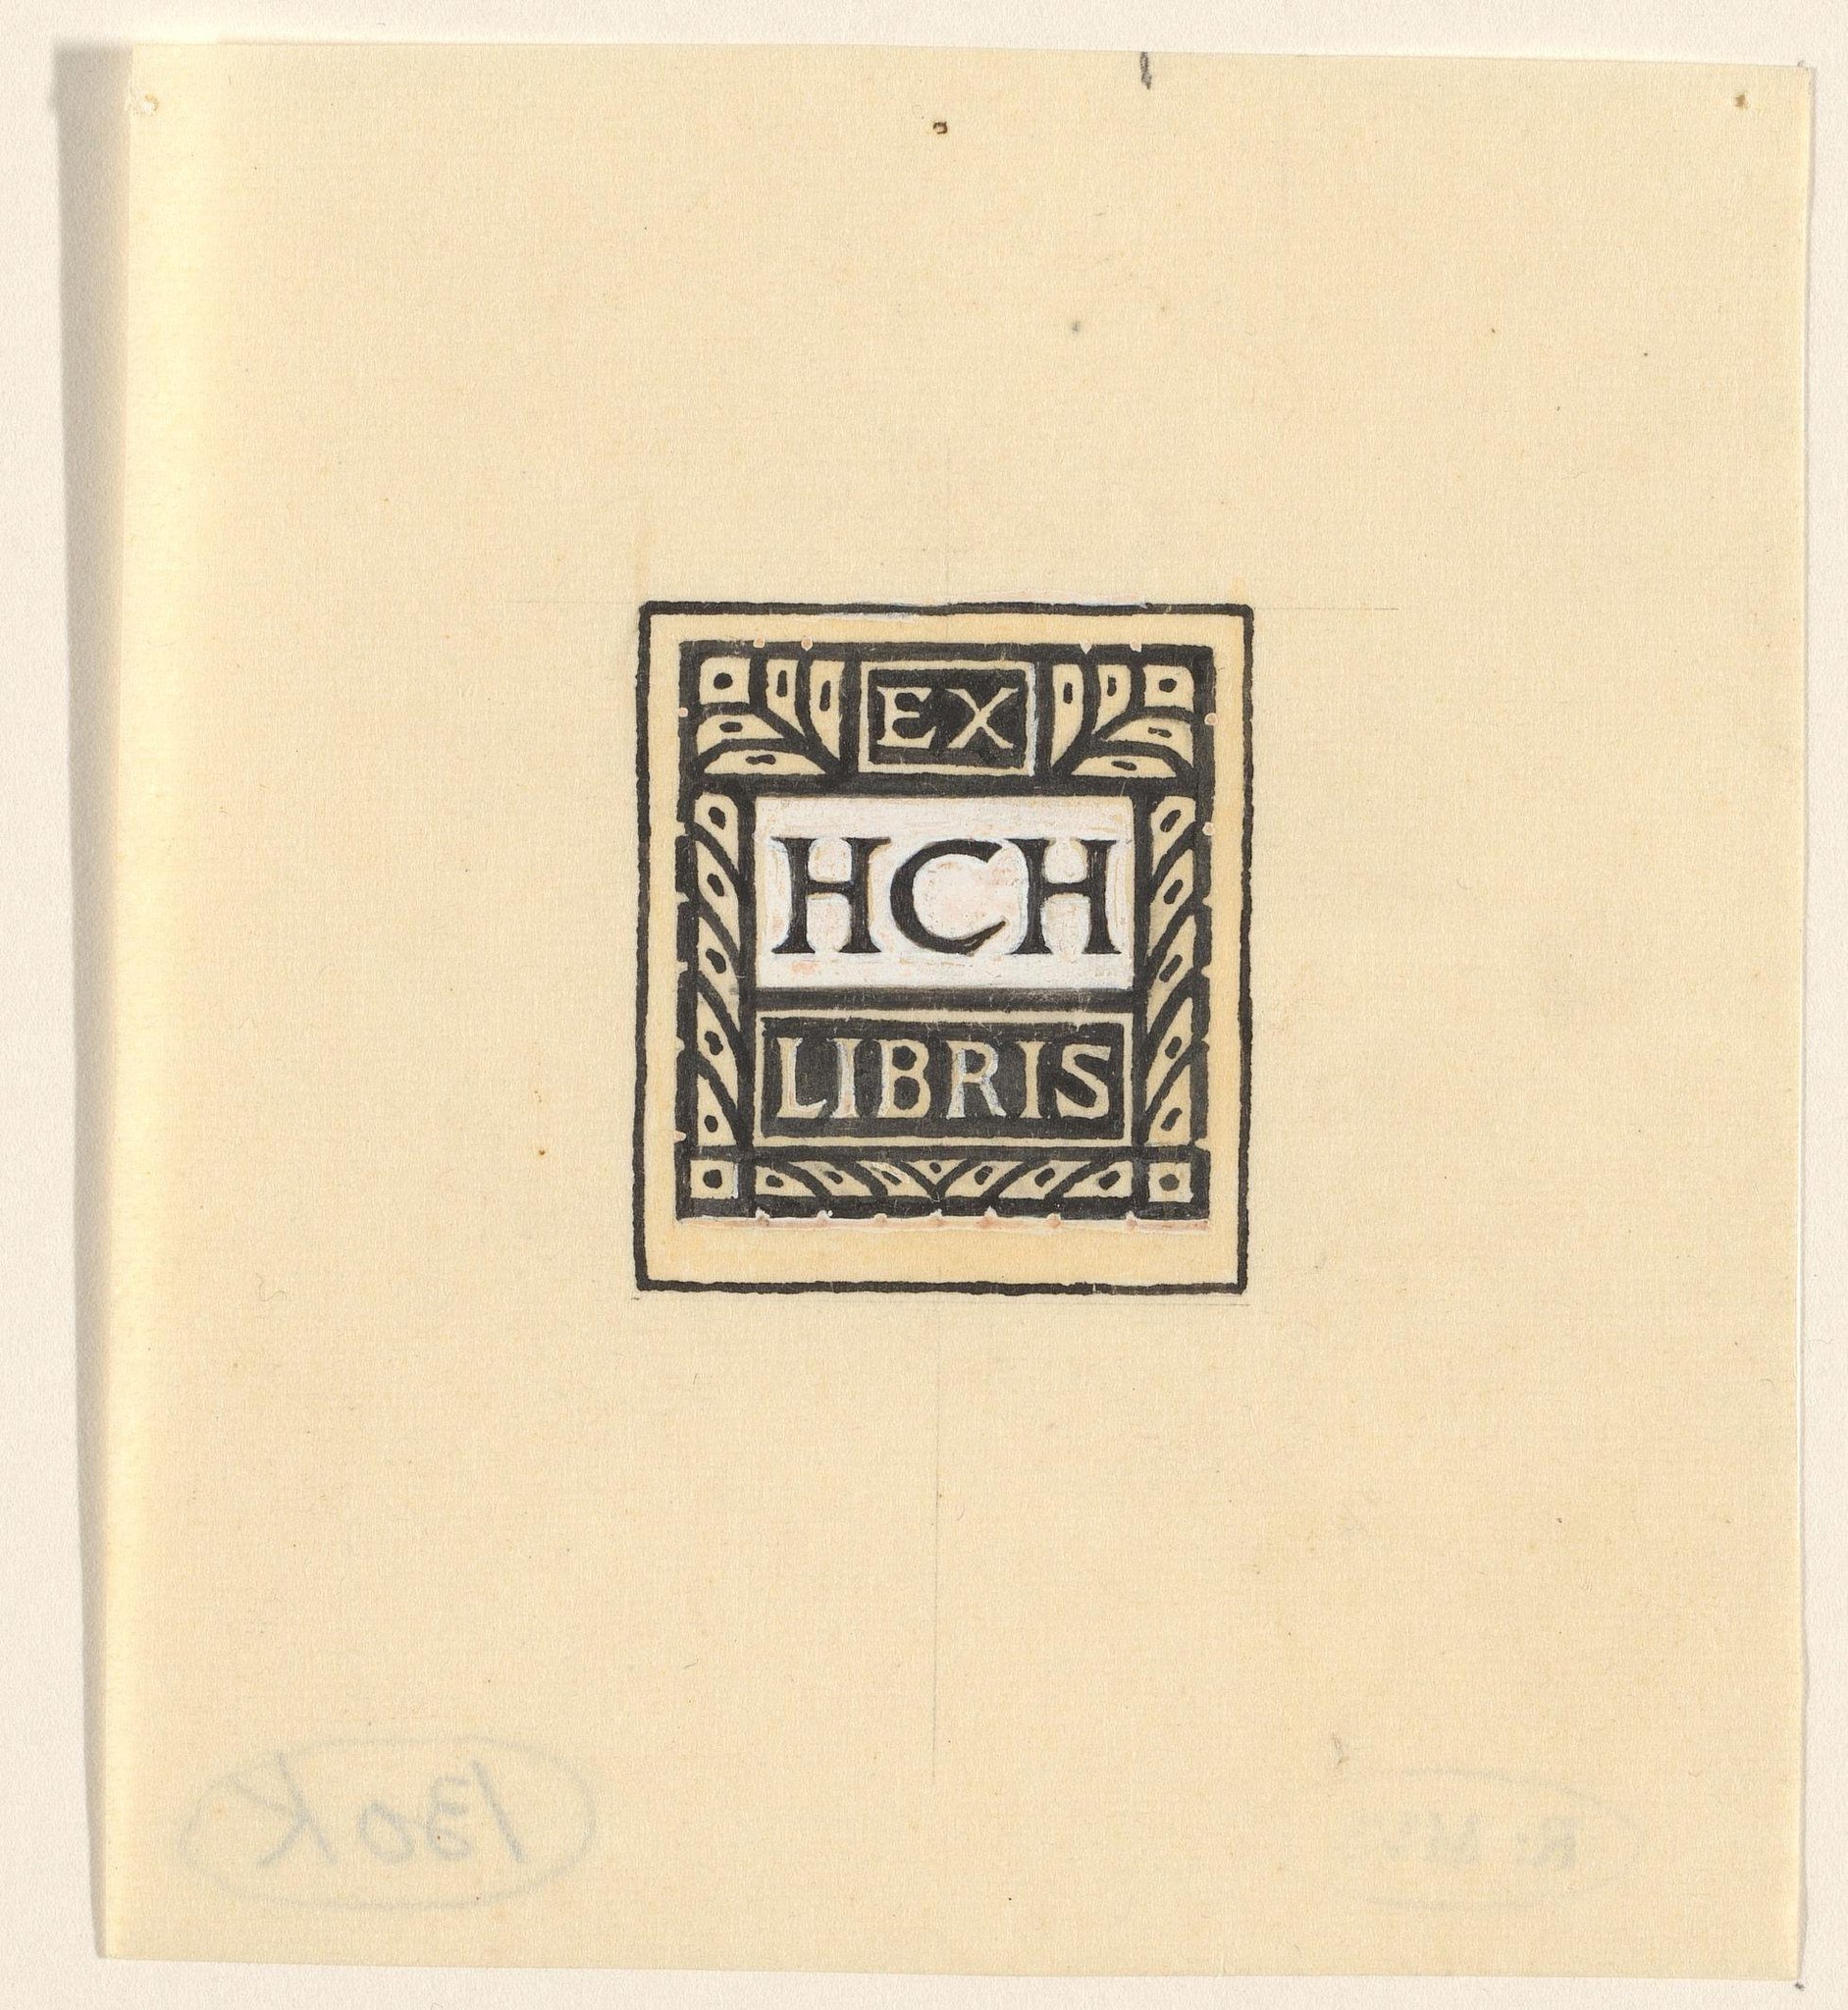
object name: design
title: Ontwerp voor een ex libris met de initialen H.C.H.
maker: julie de graag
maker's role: draughtsman, print maker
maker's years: 1877-1924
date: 1887-1924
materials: paint, ink, paper, pencil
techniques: brush, pen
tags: foliage, tendrils, branches ~ ornament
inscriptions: number: ‘130 K’